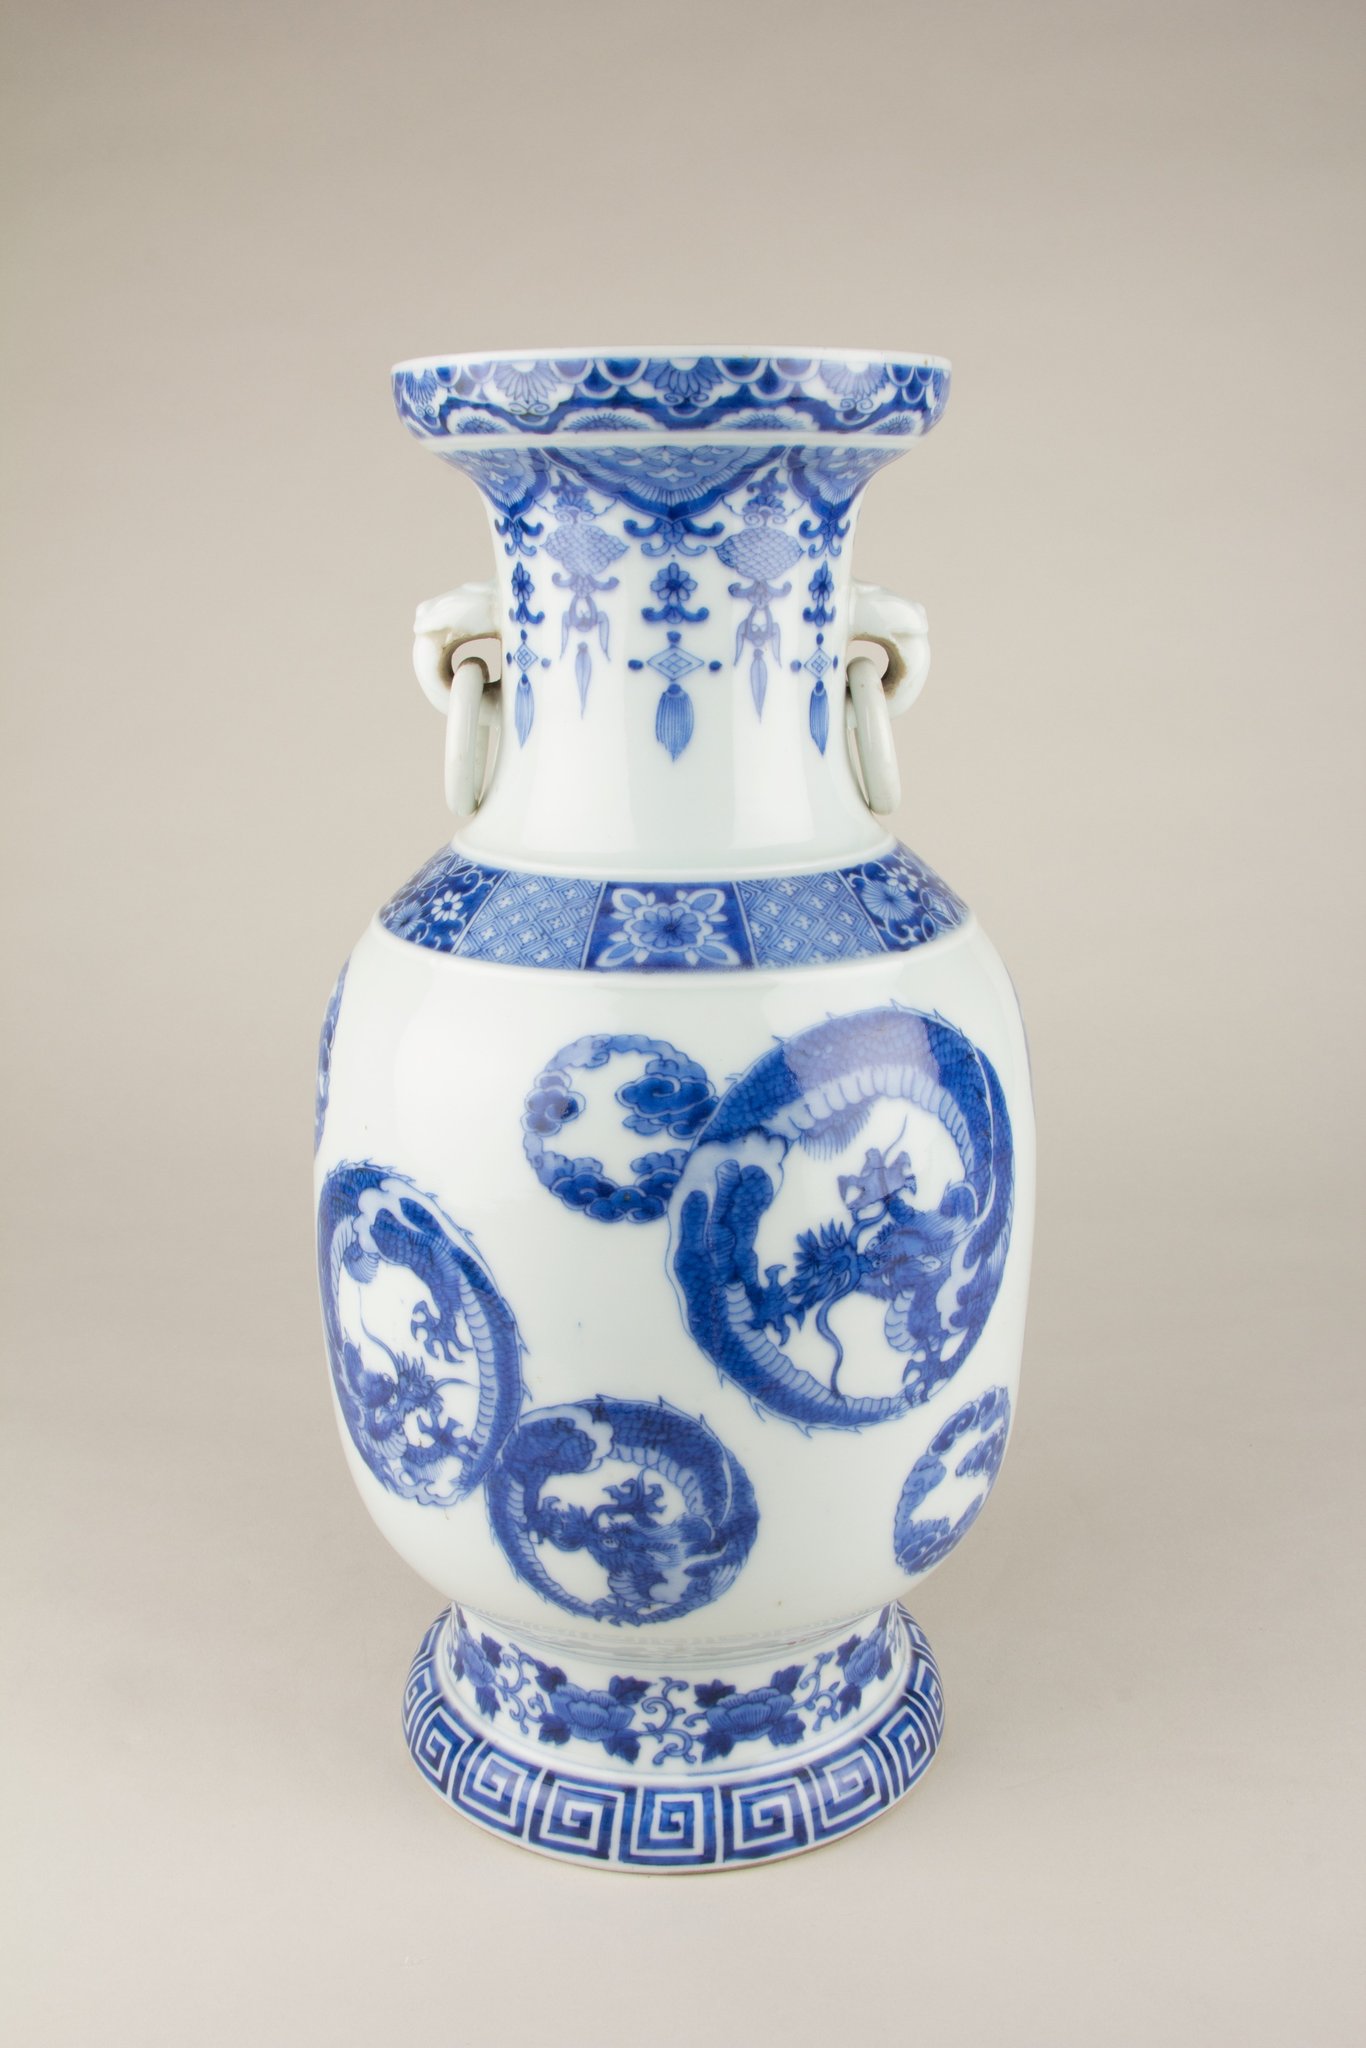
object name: vase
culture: japanese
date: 1820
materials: glaze, porcelain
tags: flowers